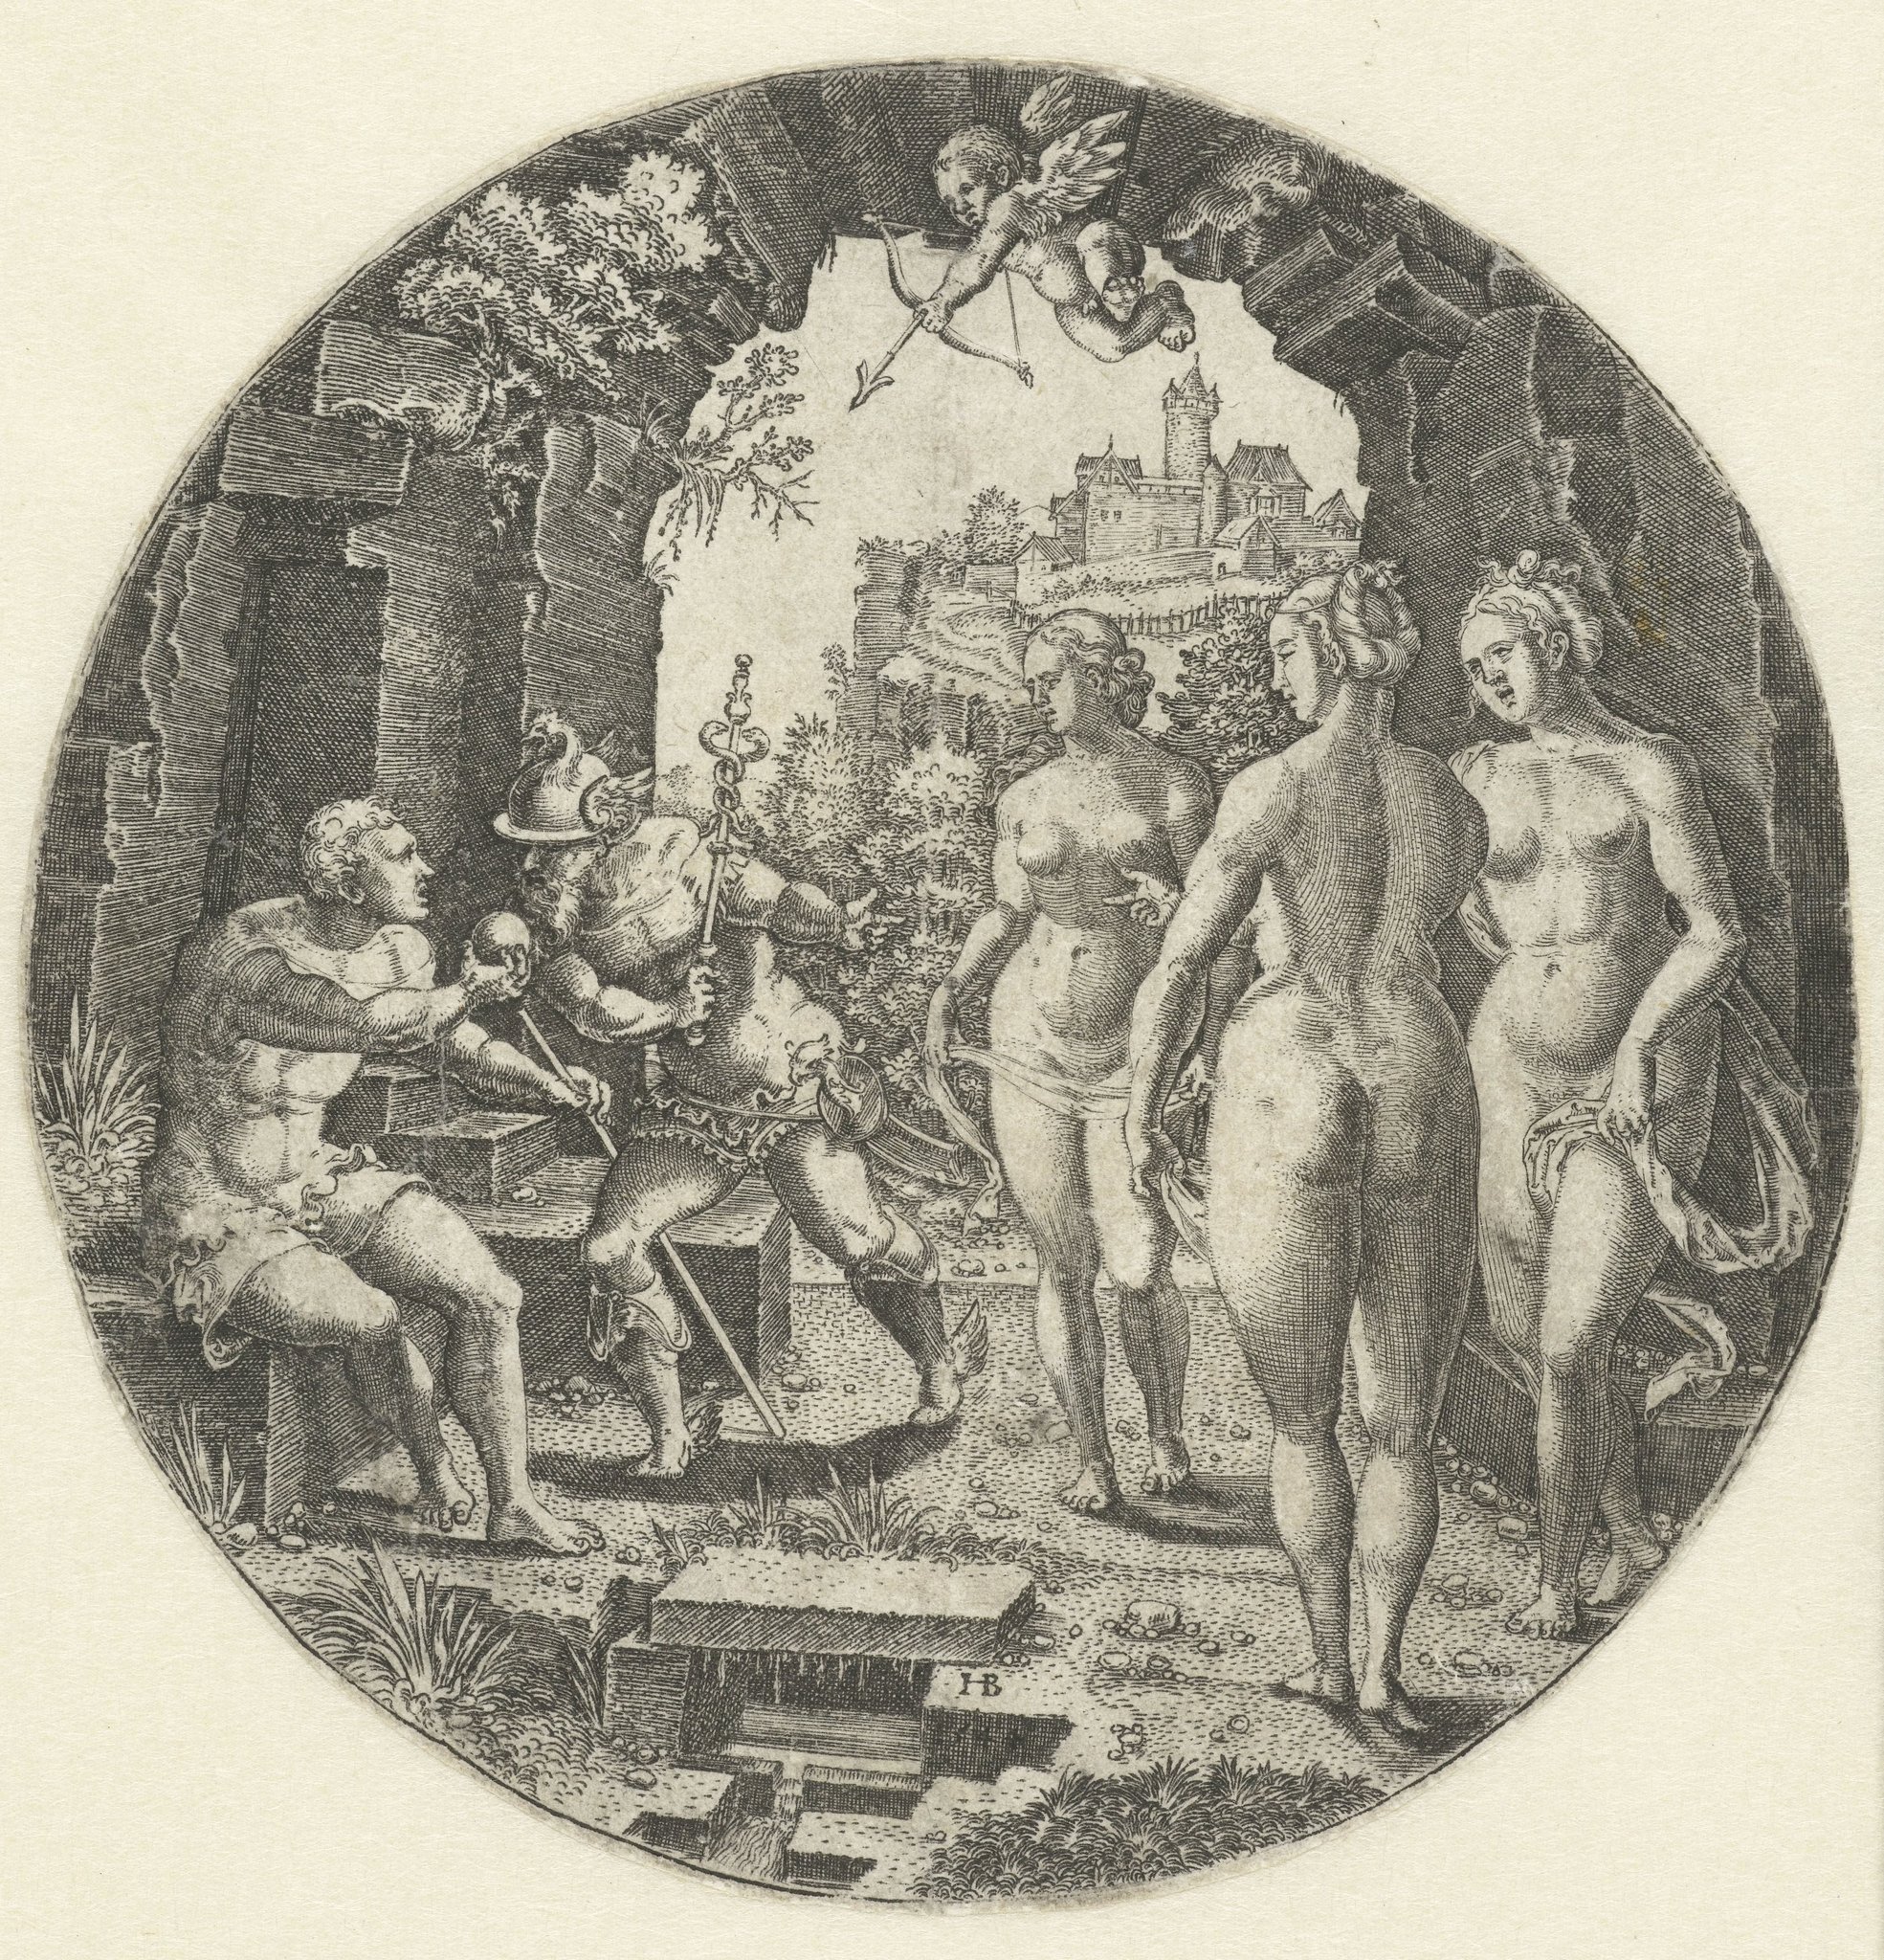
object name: print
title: Paris oordeelt of Venus, Minerva of Juno de mooiste is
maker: hans brosamer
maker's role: print maker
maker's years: 1500-1554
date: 1510-1552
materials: paper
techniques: engraving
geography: germany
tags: the judgement of paris (mercury present)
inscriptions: collector's mark: Lugt 2669, collector's mark: Lugt 2228a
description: Paris oordeelt of Venus, Minerva of Juno de mooiste vrouw is. Hij heeft een gouden appel in zijn hand welke hij aan Venus zal geven, de winnares van deze schoonheidswedstrijd. Boven in de lucht zweeft Amor met pijl en boog.